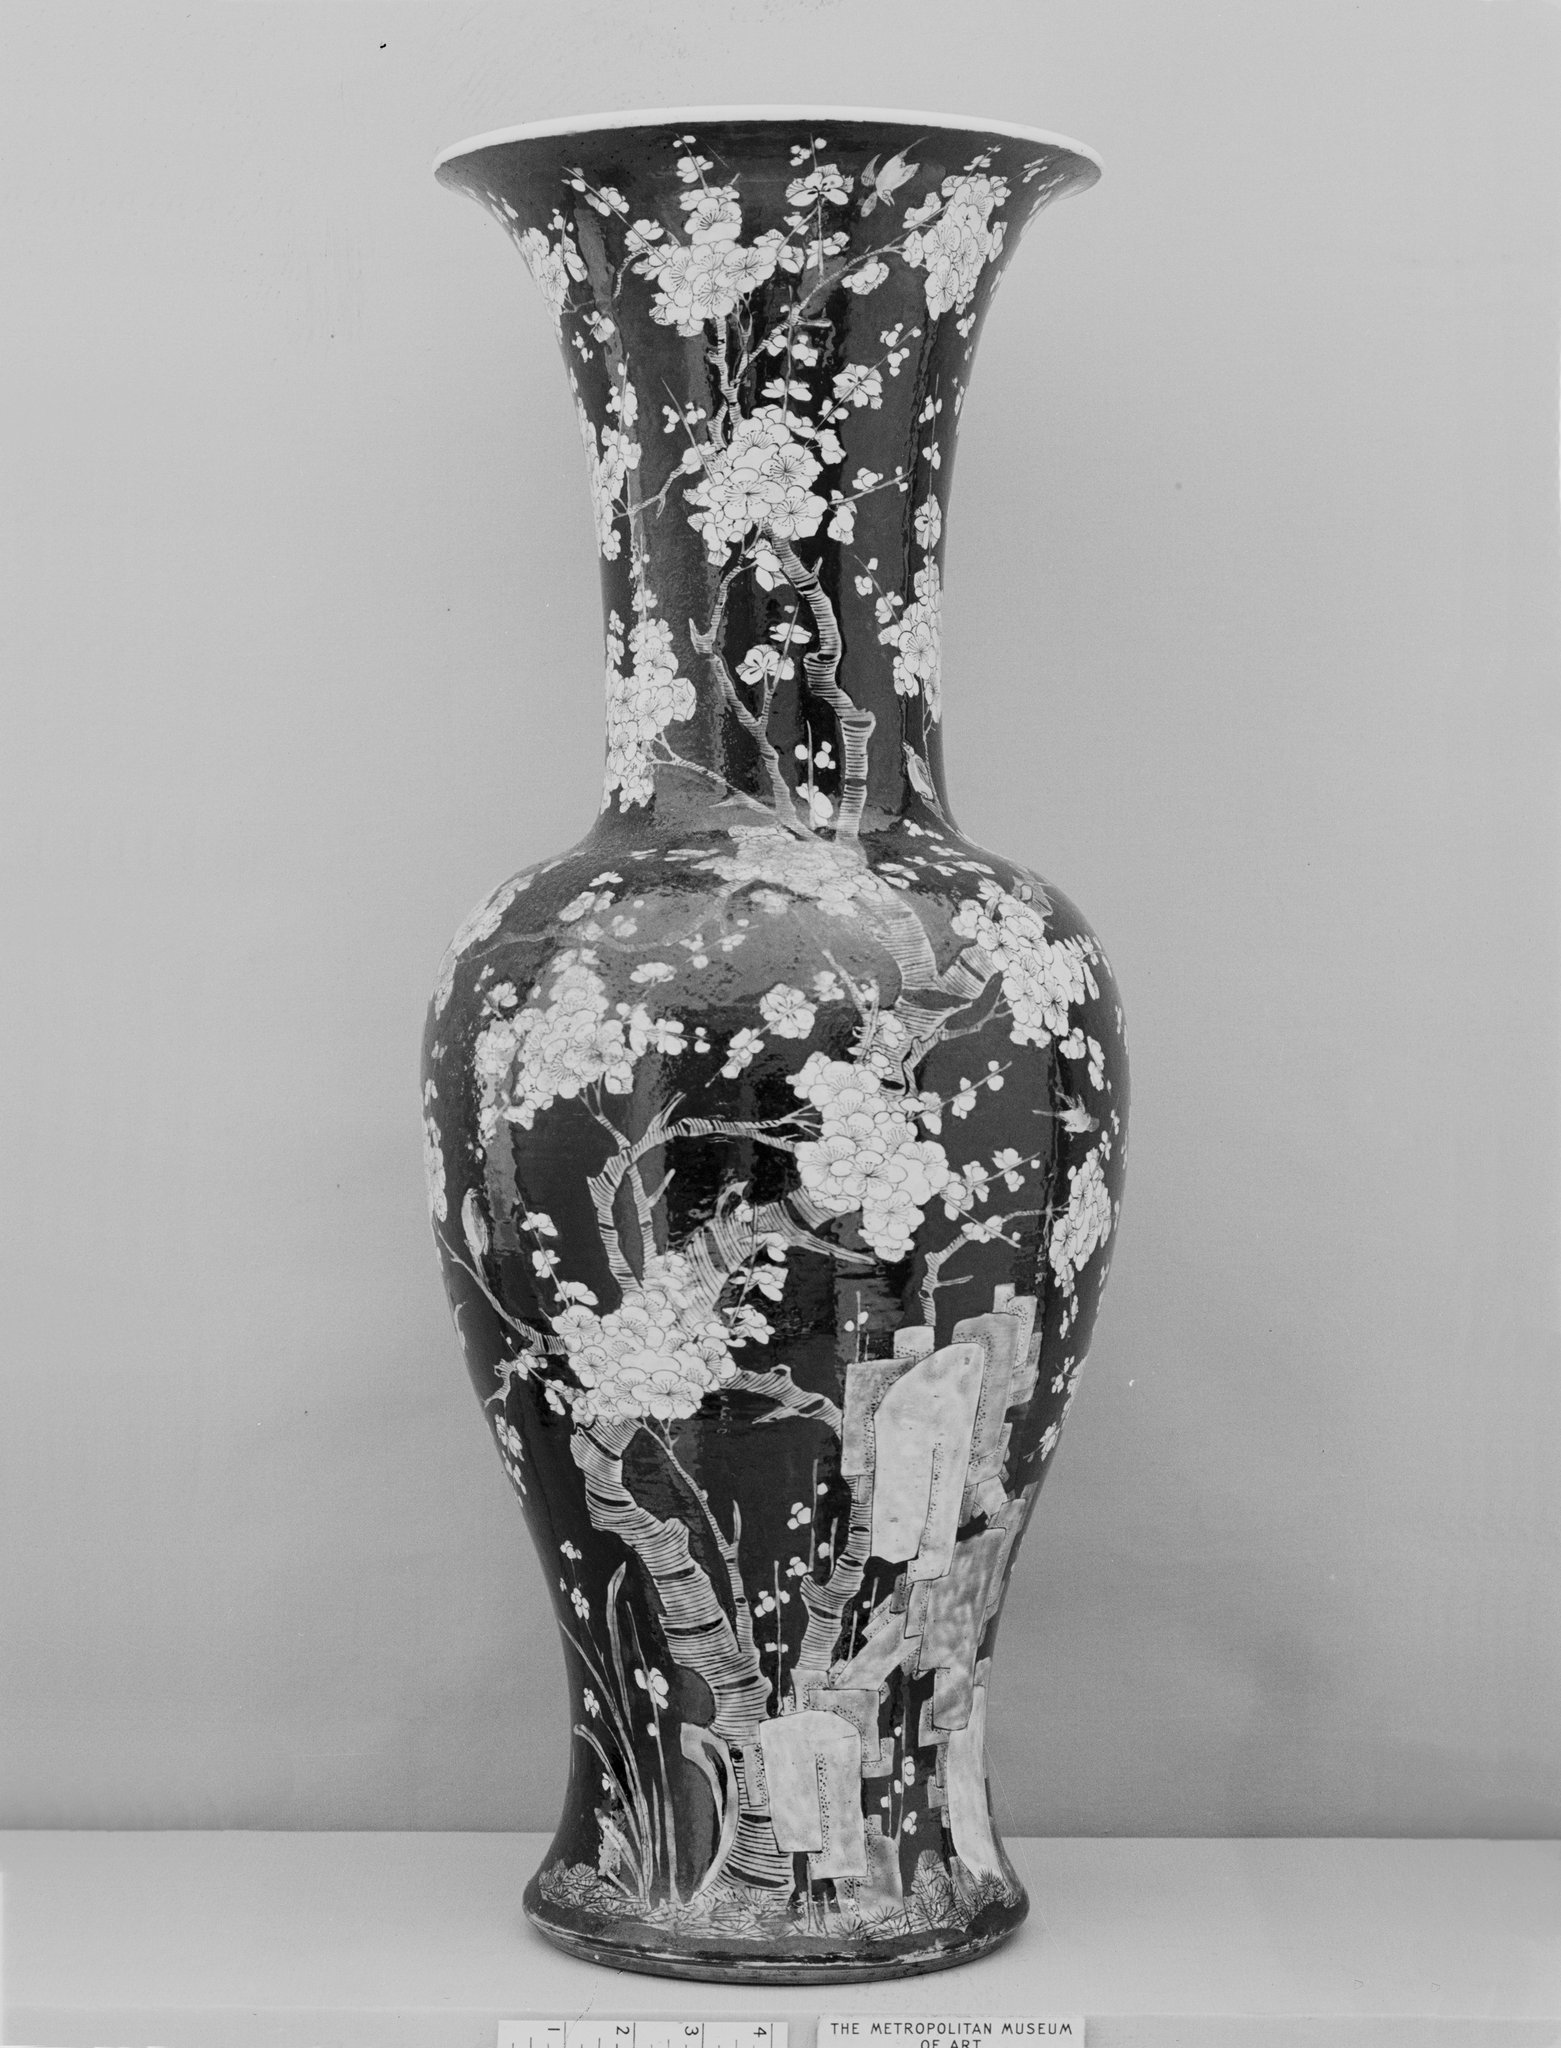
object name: vase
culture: chinese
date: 1662-1722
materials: porcelain